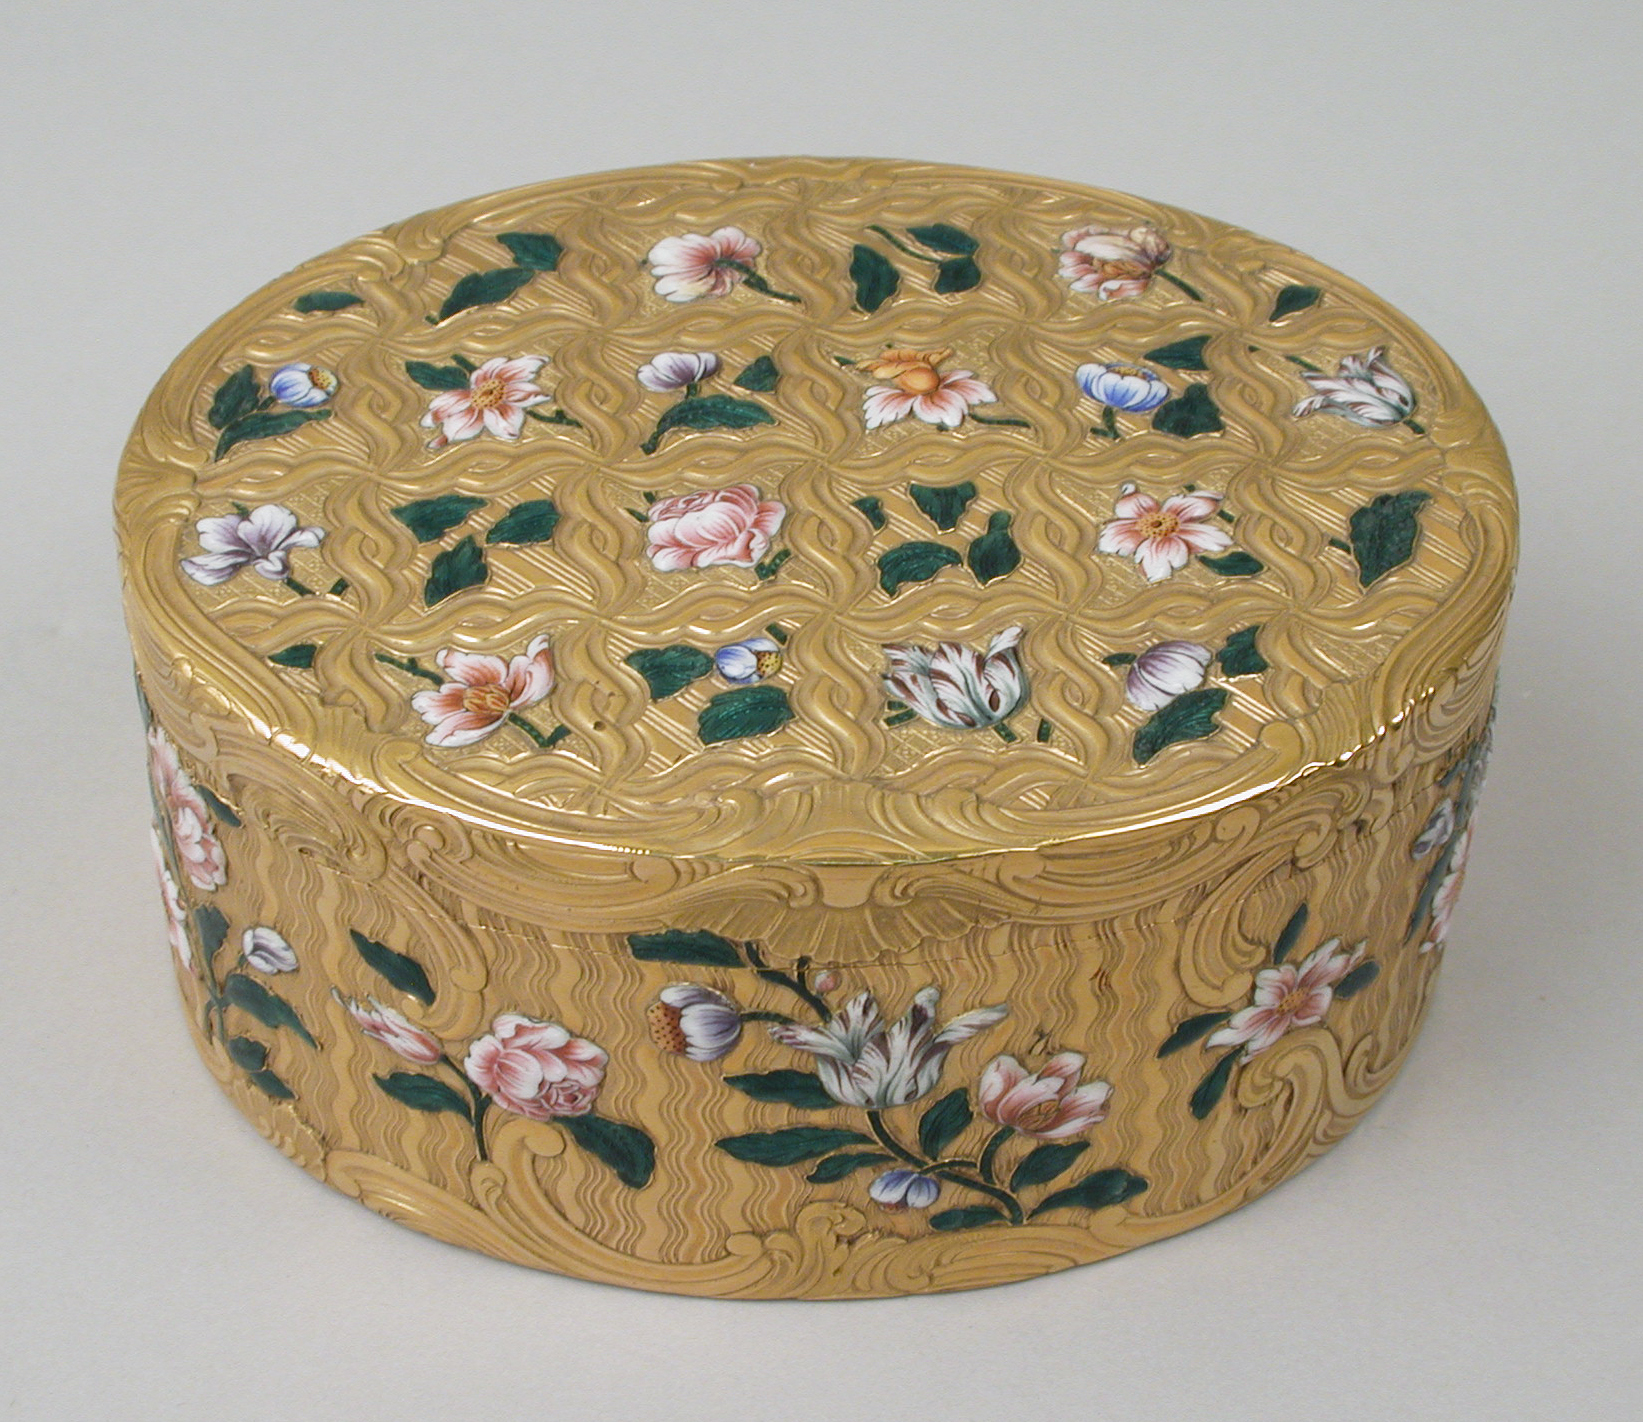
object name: snuffbox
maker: jean frémin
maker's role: maker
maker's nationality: french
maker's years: 1738-1786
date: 1756-1757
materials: enamel, gold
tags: flowers